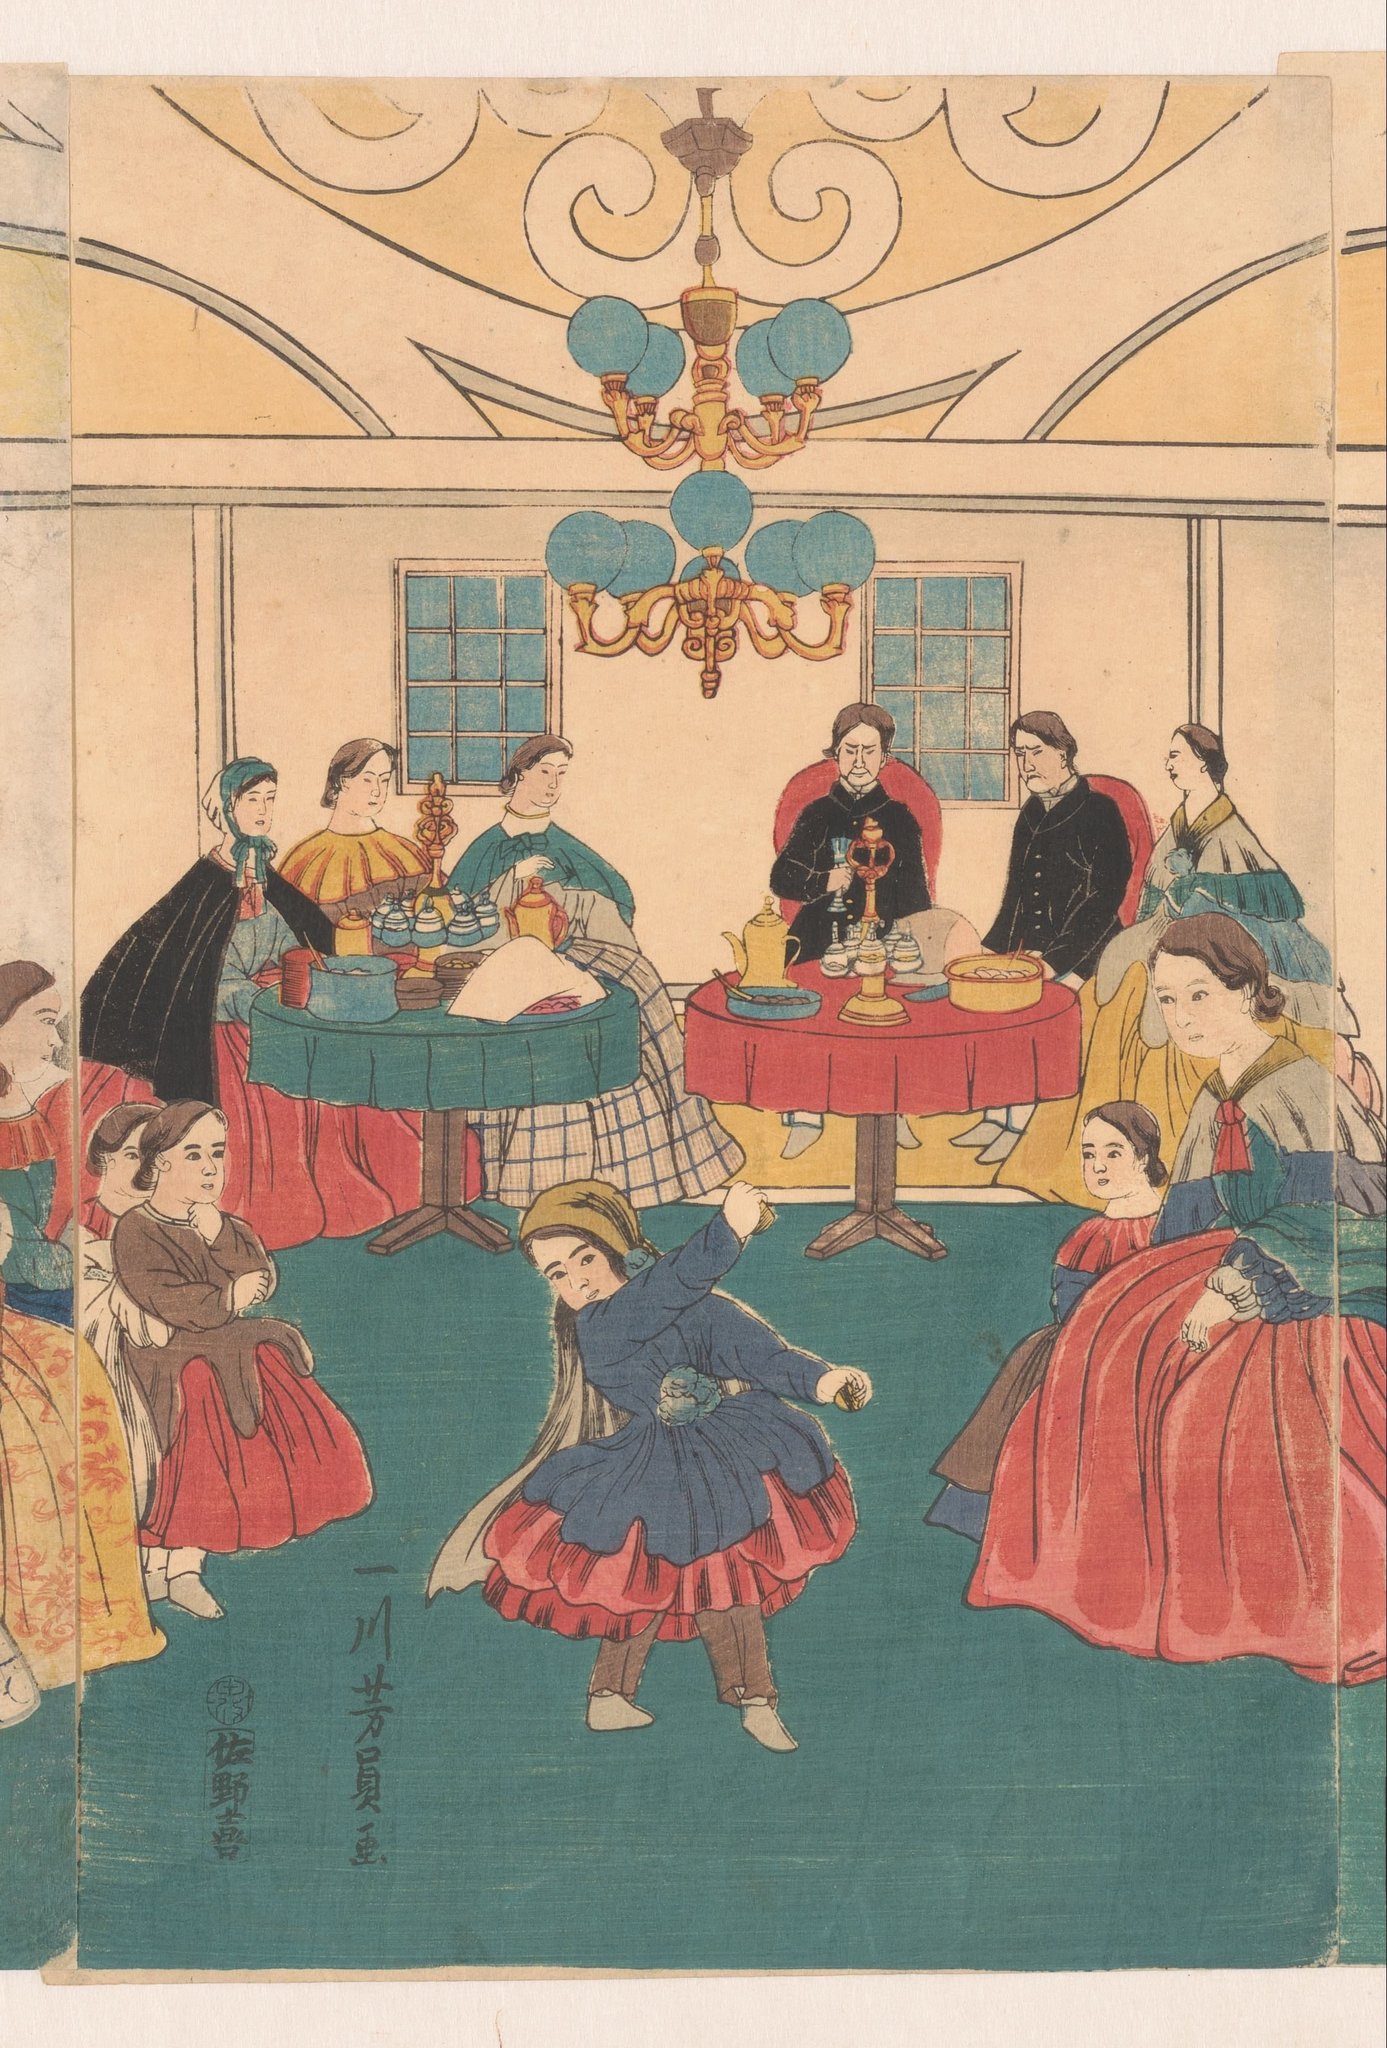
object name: print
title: Buitenlanders vermaken zich tijdens een banket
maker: utagawa yoshikazu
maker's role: print maker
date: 1812-1860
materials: paper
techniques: woodcut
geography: japan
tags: visiting; receiving guests; elegant company, celebration meal, feast, banquet, human races; peoples; nationalities